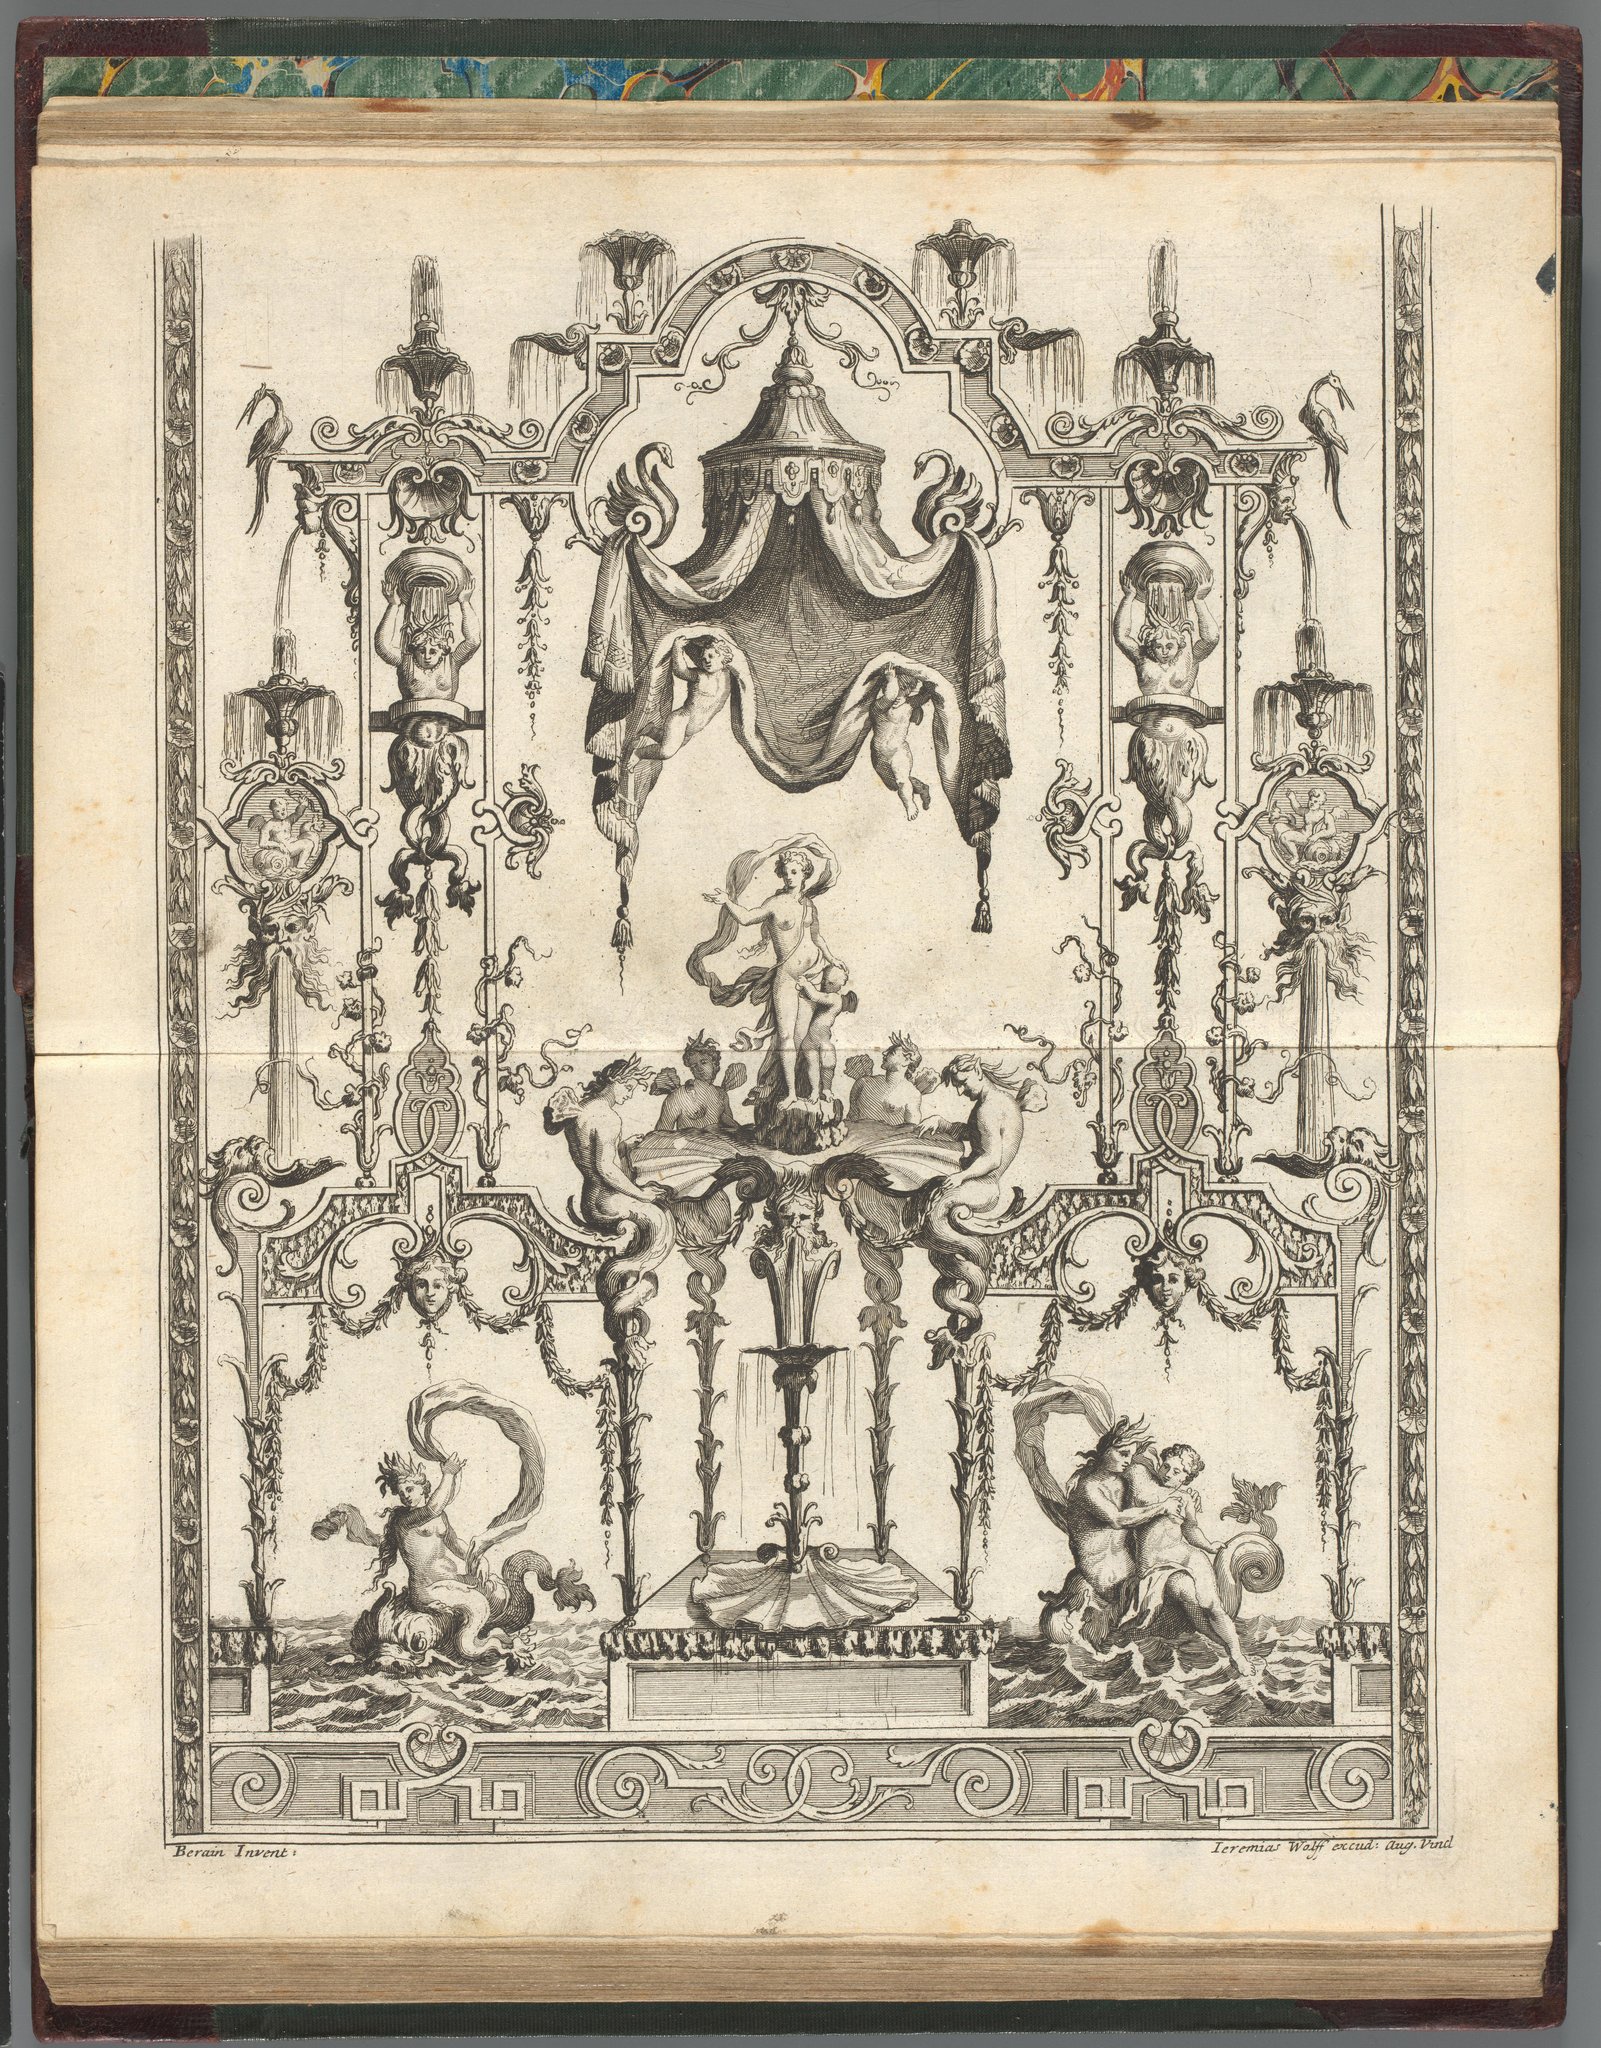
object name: print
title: Compositie met Venus Anadyomene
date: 1686-1724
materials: paper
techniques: etching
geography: augsburg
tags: ornaments ~ art, canopy, baldachin, birth of venus; venus anadyomene: after uranus' castration venus rises from the sea wringing the water from her hair; usually she is awaited by the hours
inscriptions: signature: ‘Berain Invent.’, signature: ‘Ieremias Wolff excud. Aug. Vind.’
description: Een decoratieve compositie met fonteinen en in het midden Venus Anadyomene op een schelp onder een baldakijn. Rondom de schelp meerminnen. Links- en rechts onder zitten een meermin en een meerman met een vrouw op dolfijnen. Prent maakt deel uit van een album. Hoogstwaarschijnlijk gespiegelde kopie naar Frans origineel.